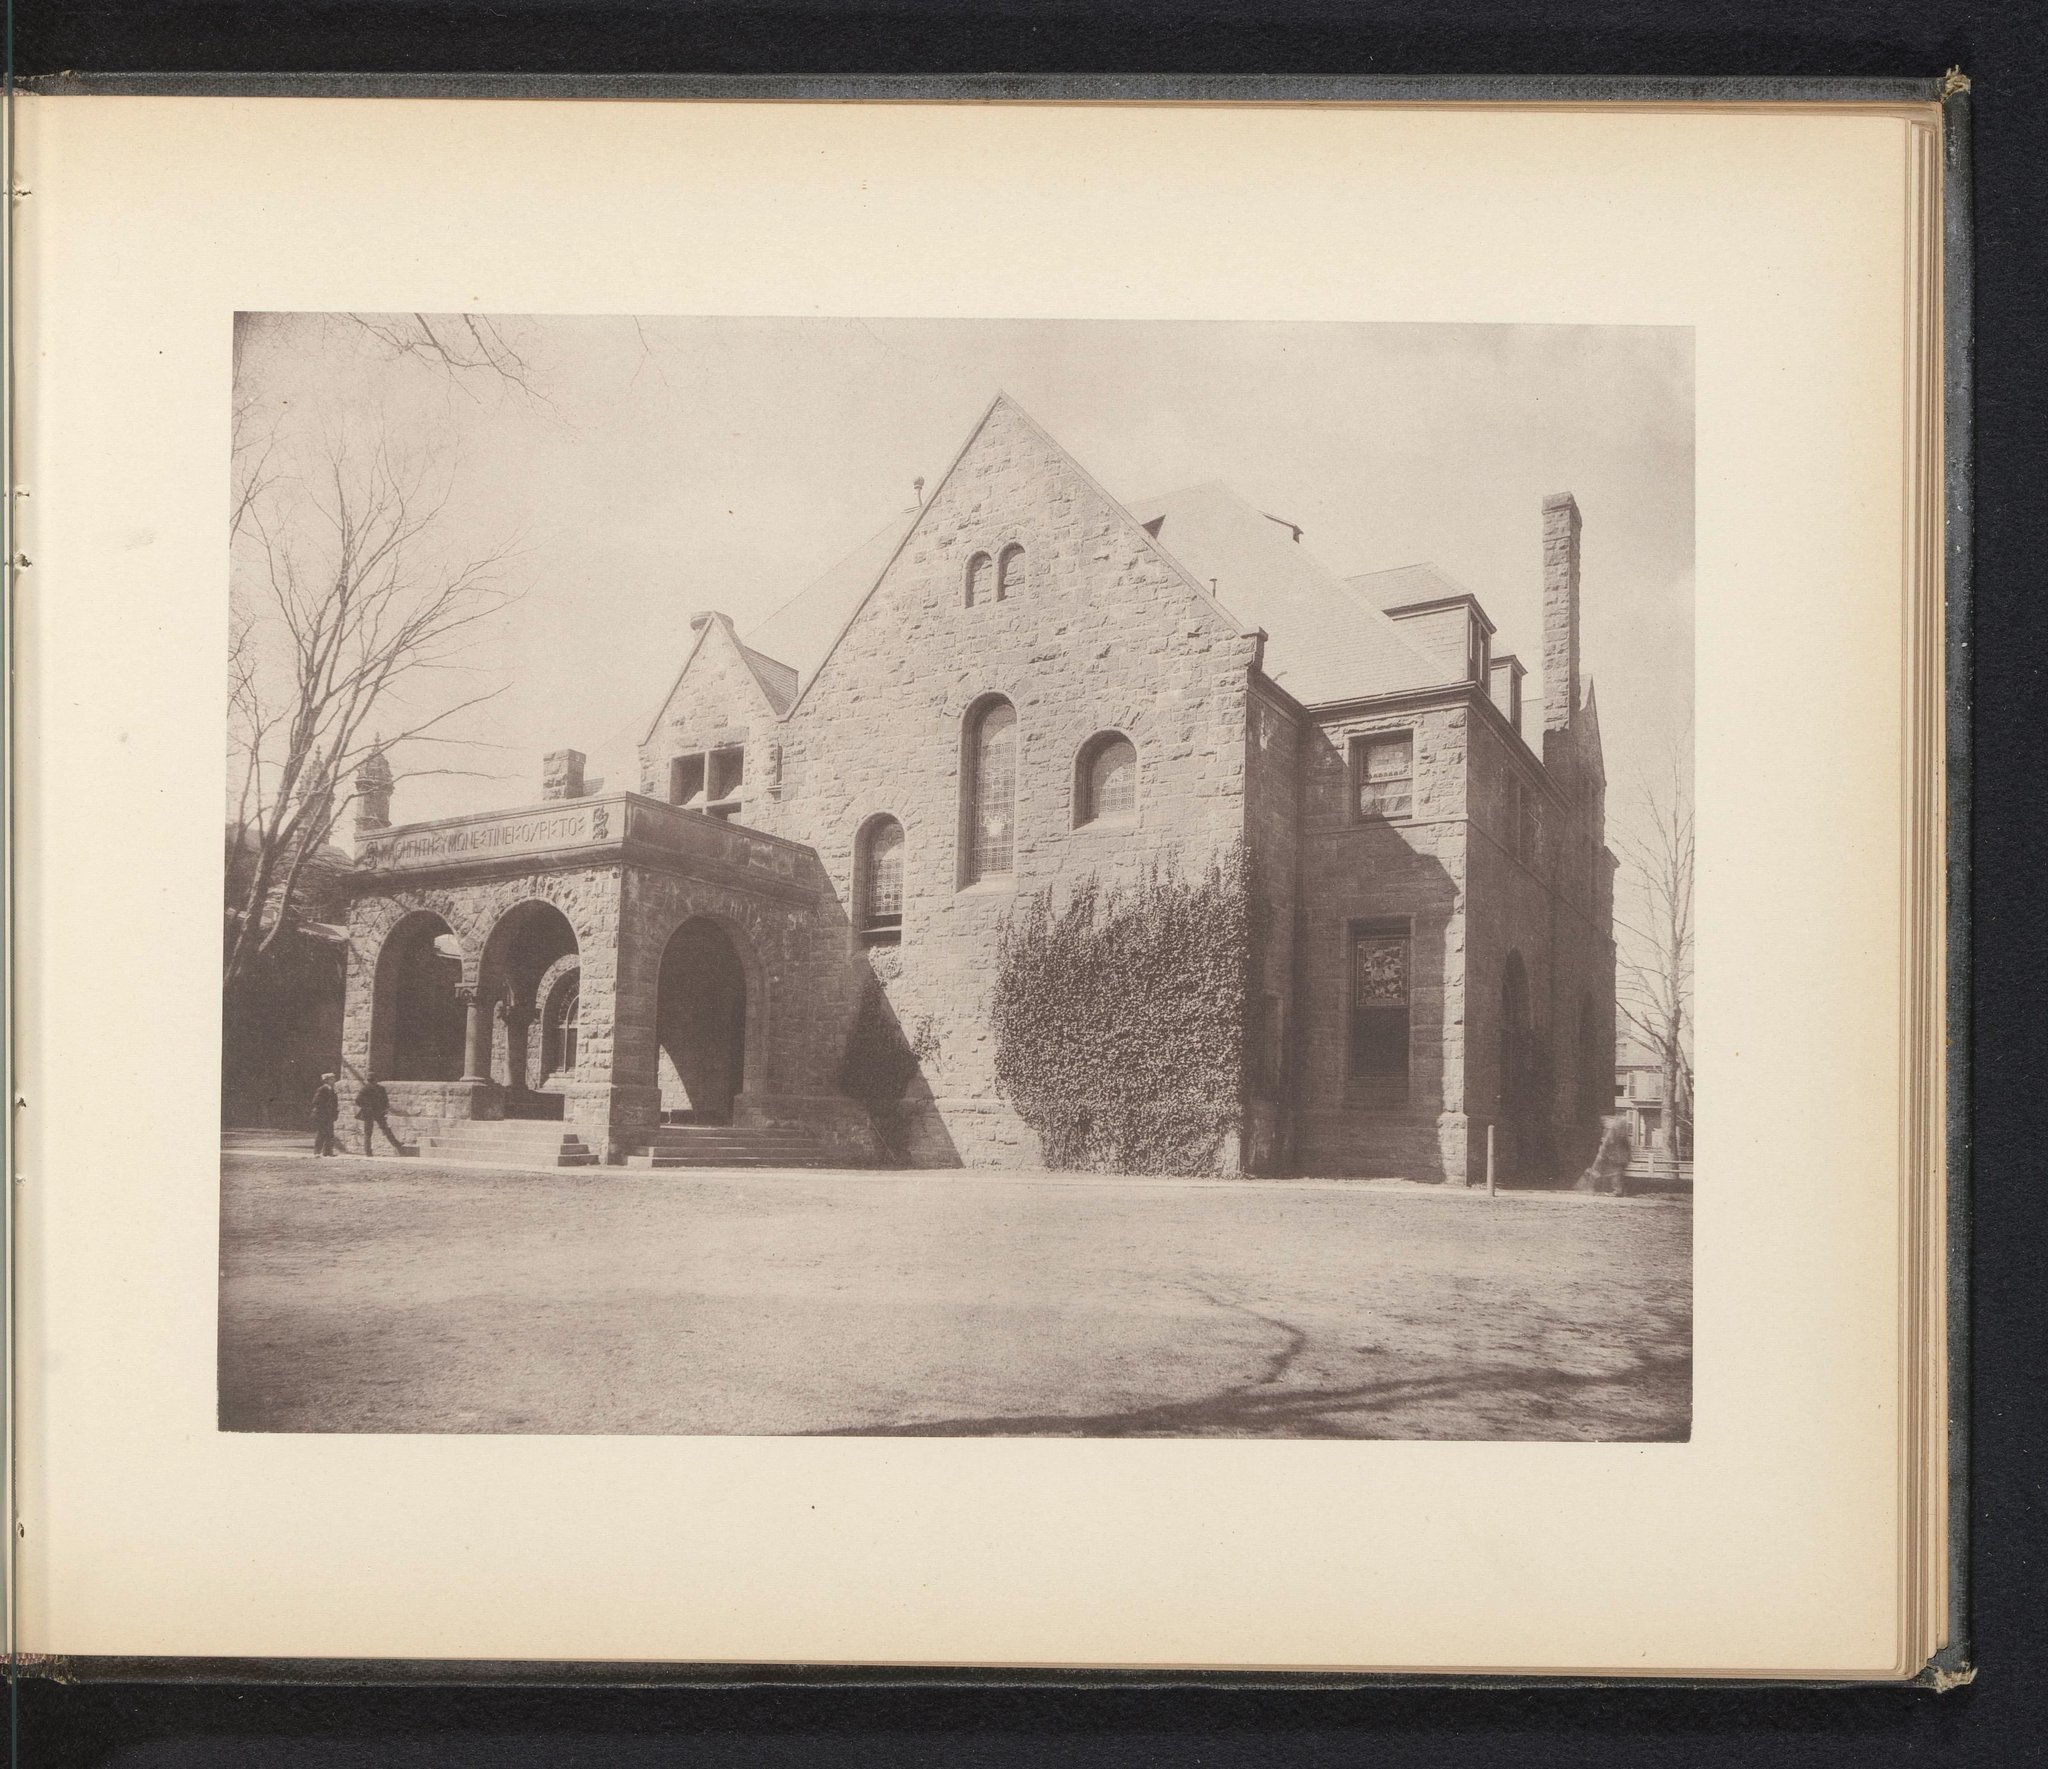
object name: photomechanical print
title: Exterieur van Dwight Hall van Yale University te New Haven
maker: Anonymous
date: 1890-1895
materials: paper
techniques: photograph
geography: new york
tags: university building, college, façade (of house or building)